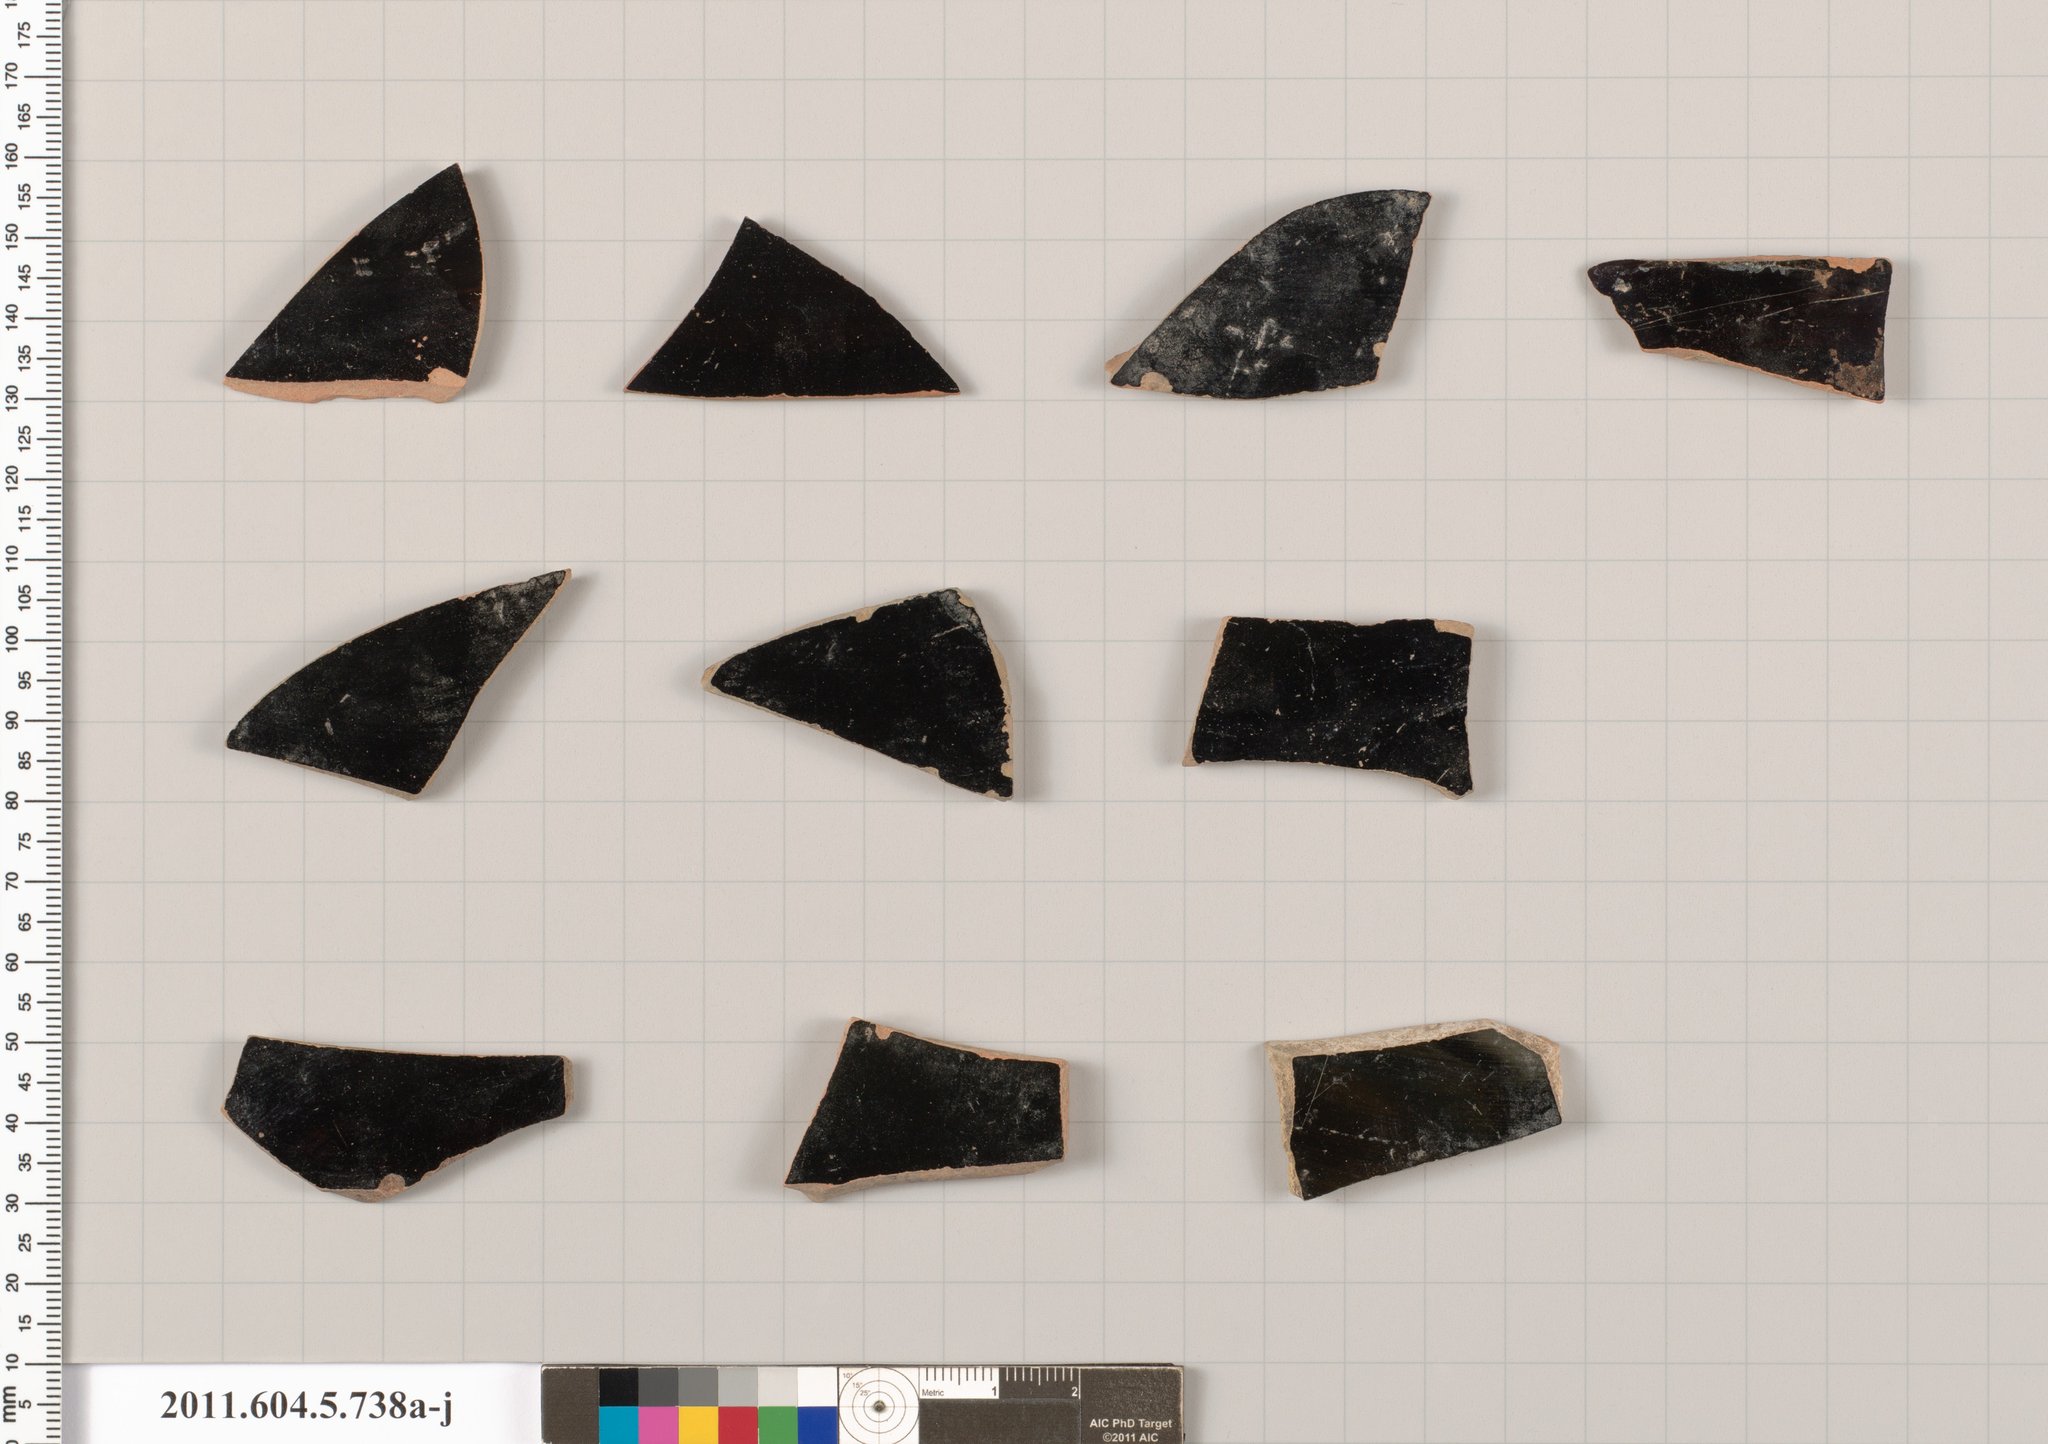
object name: kylix fragment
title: Terracotta fragments of kylikes (drinking cups)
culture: greek, attic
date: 600-401 BCE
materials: terracotta